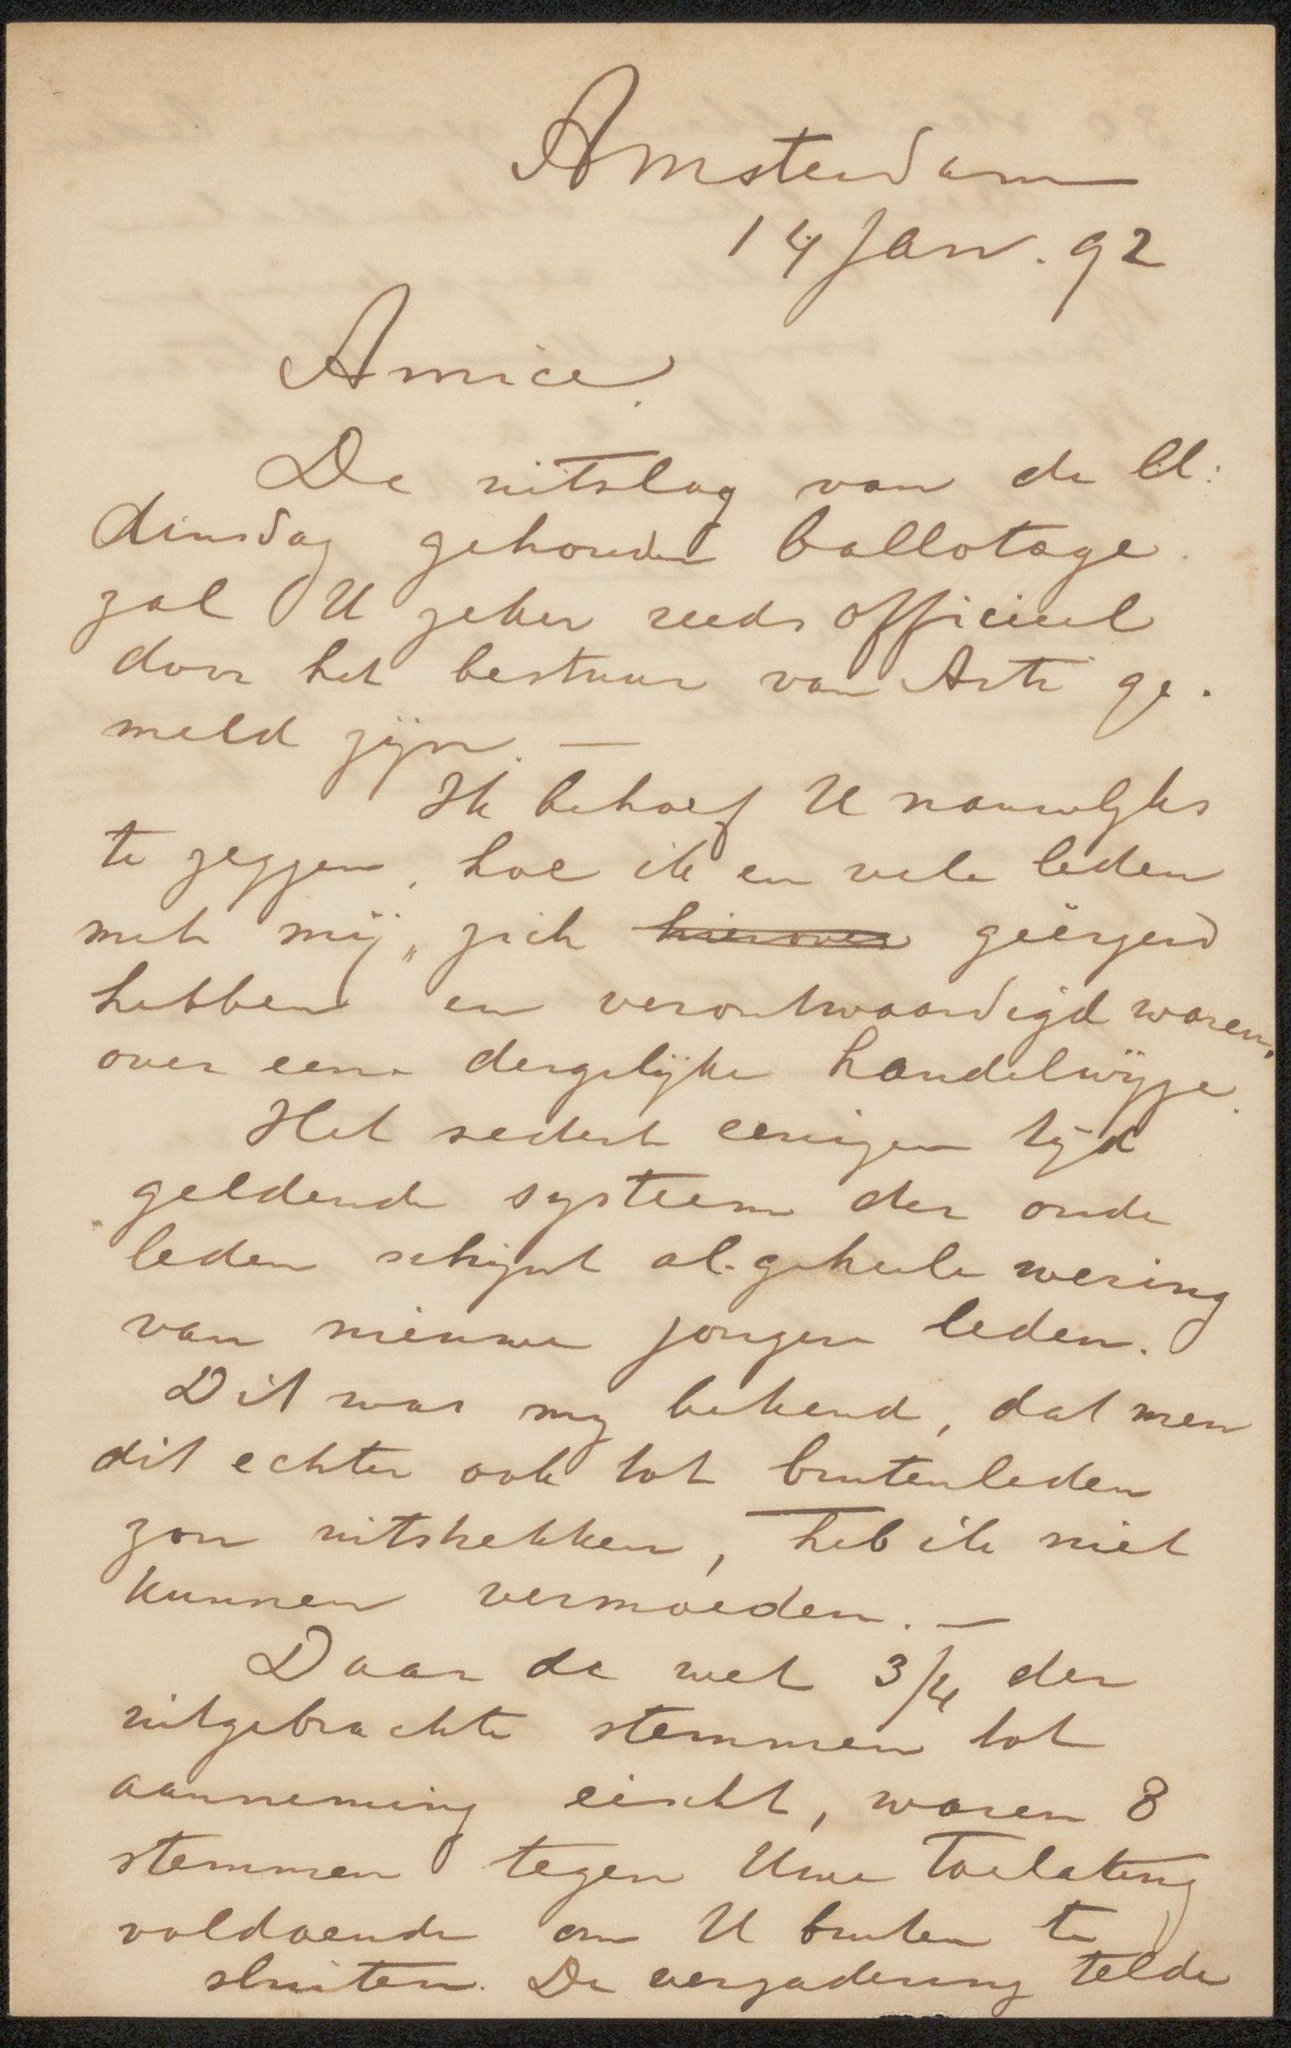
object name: letter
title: Brief aan Philip Zilcken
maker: geo poggenbeek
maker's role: draughtsman, painter, print maker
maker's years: 1853-1903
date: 1892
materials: ink, paper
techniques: pen, writing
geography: amsterdam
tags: willem witsen, designer, willem wenckebach, the hague, painter, philip zilcken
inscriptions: collector's mark: ‘RPK’